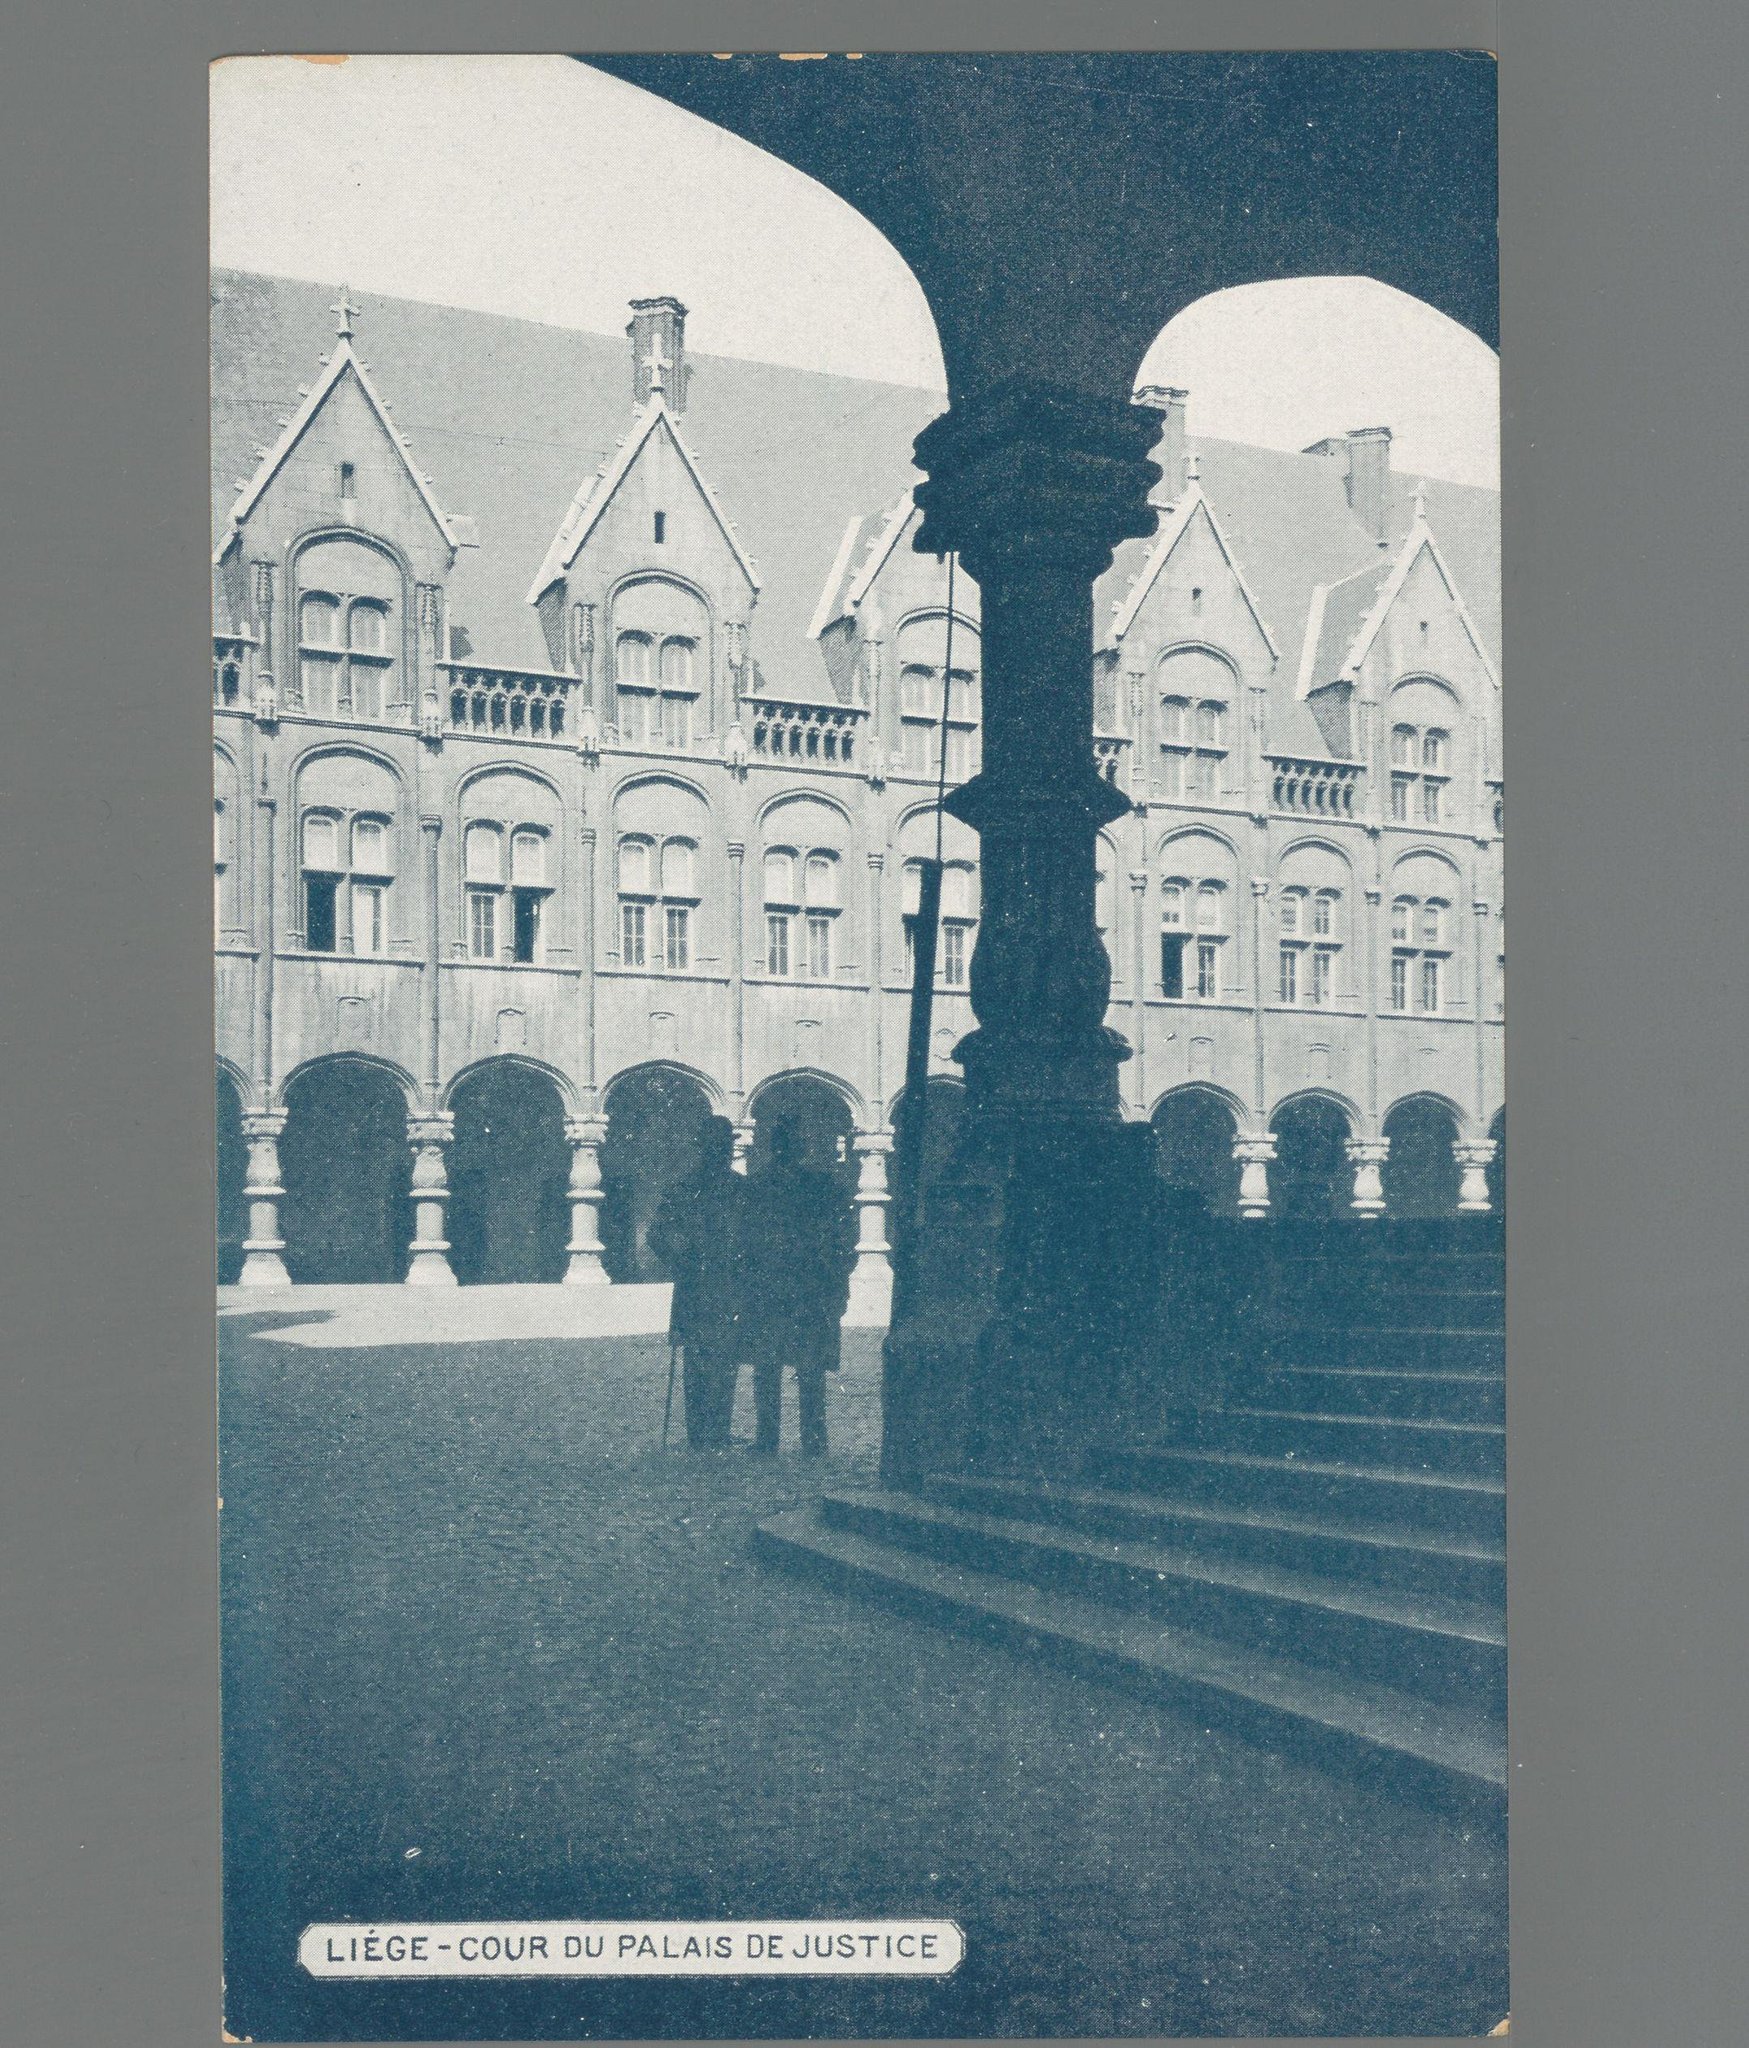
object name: photomechanical print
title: Liège. Cour du Palais de Justice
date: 1909-1913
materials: cardboard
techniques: autotype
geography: antwerp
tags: court building, courtyard, liège